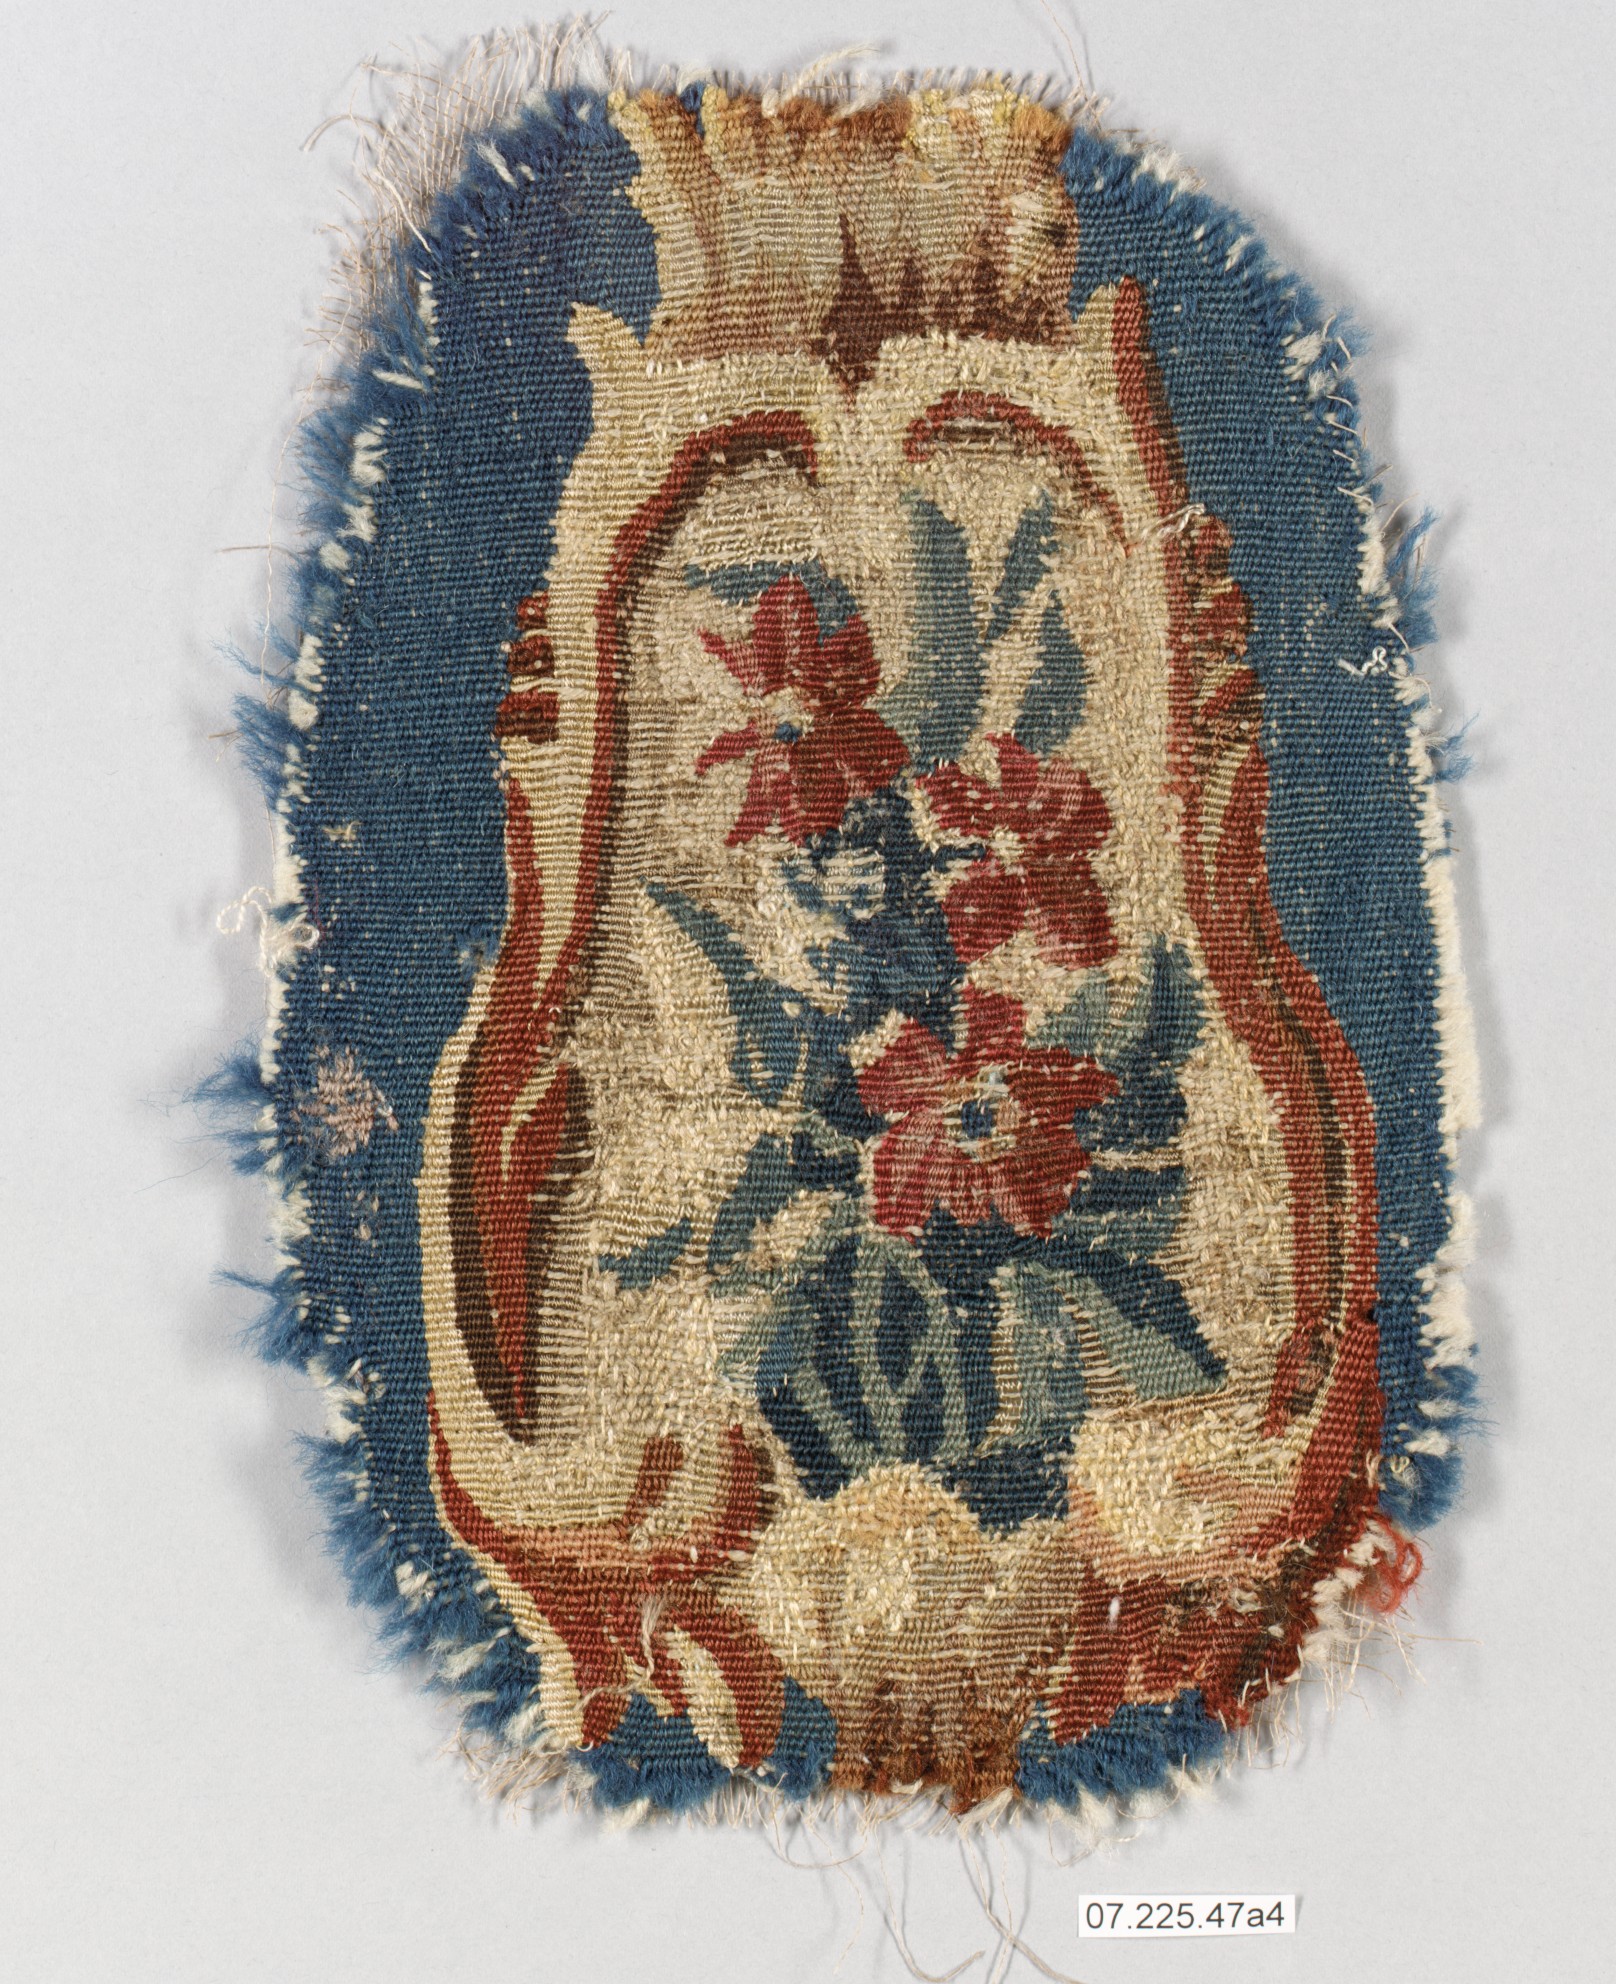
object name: upholstery panel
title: Rocaille cartouche with flowers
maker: beauvais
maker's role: manufactory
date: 1735-1750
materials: silk, wool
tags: flowers